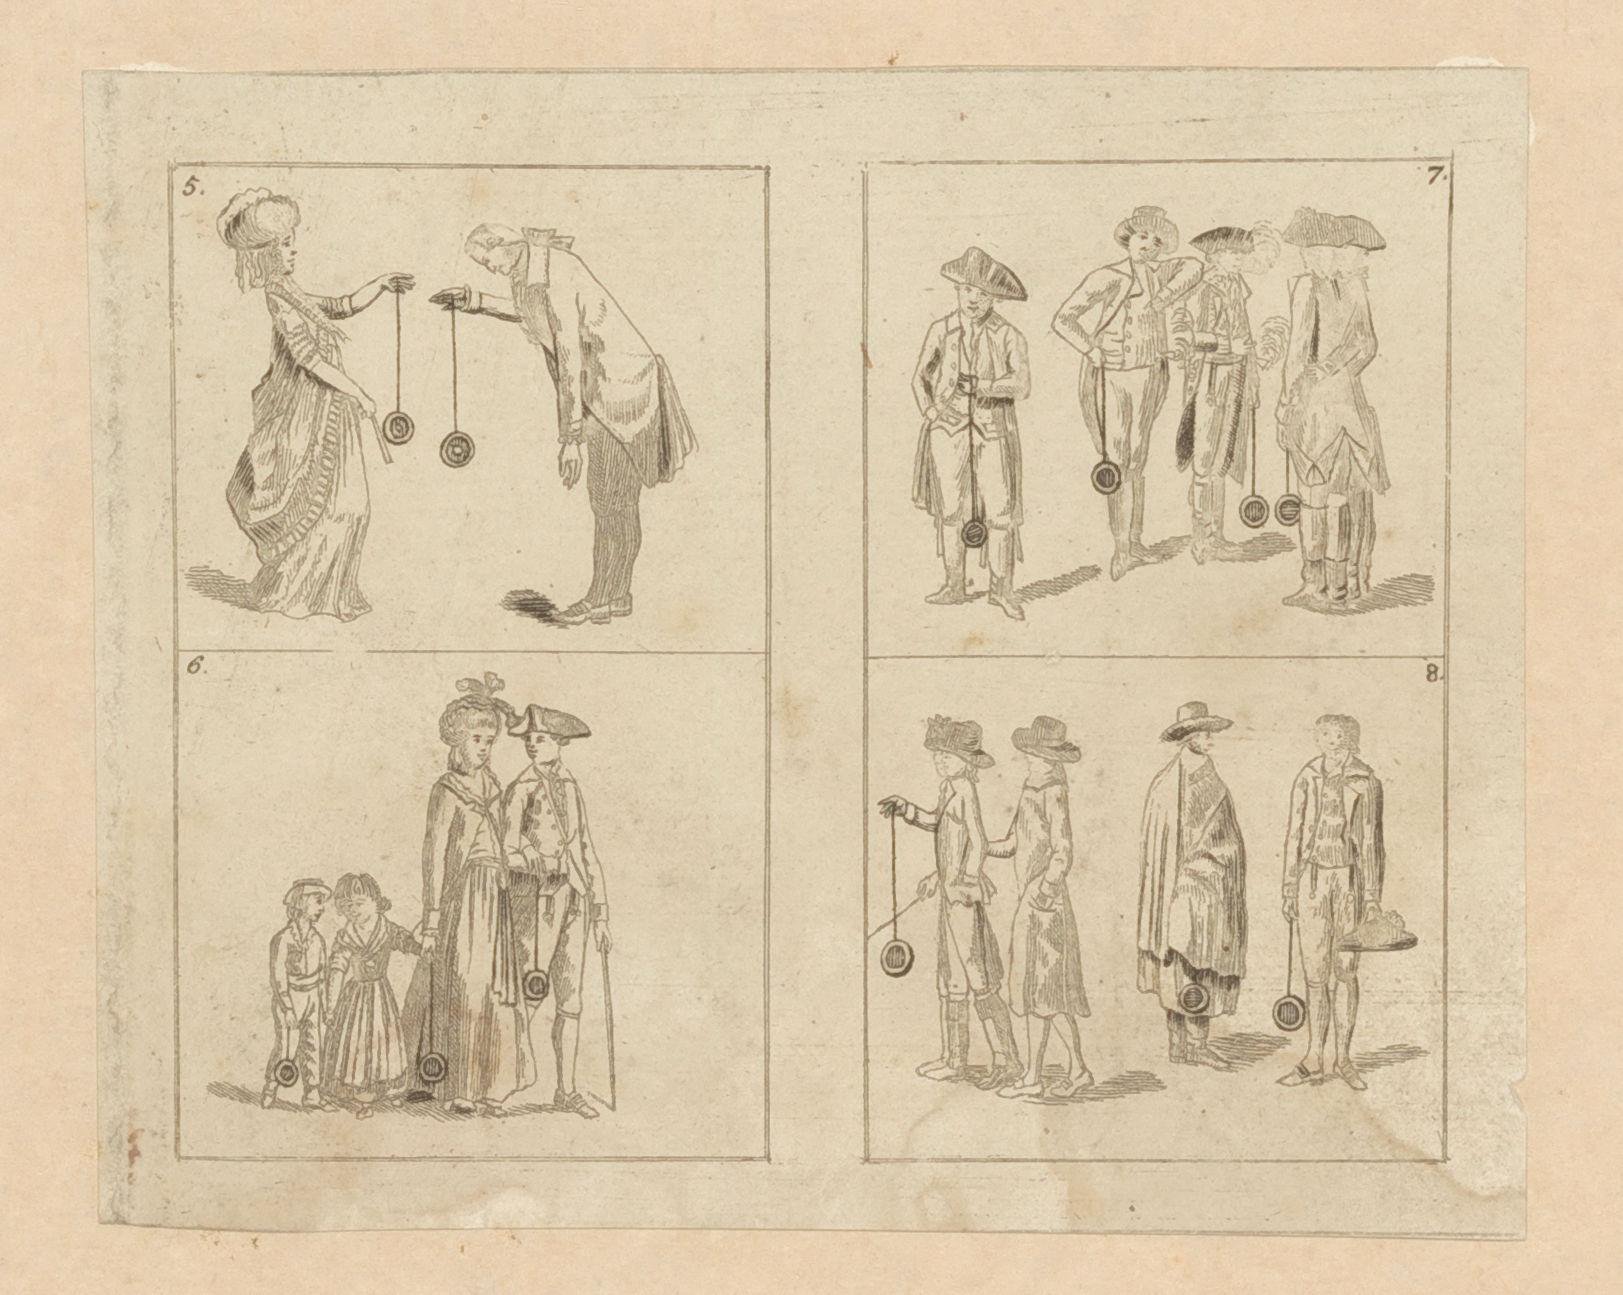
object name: print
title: Vier afbeeldingen uit de Almanach de Joe Joe MDCCLXXXXII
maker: Anonymous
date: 1792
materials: paper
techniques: engraving, etching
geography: netherlands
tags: yoyo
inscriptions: collector's mark, collector's mark: Lugt 1641